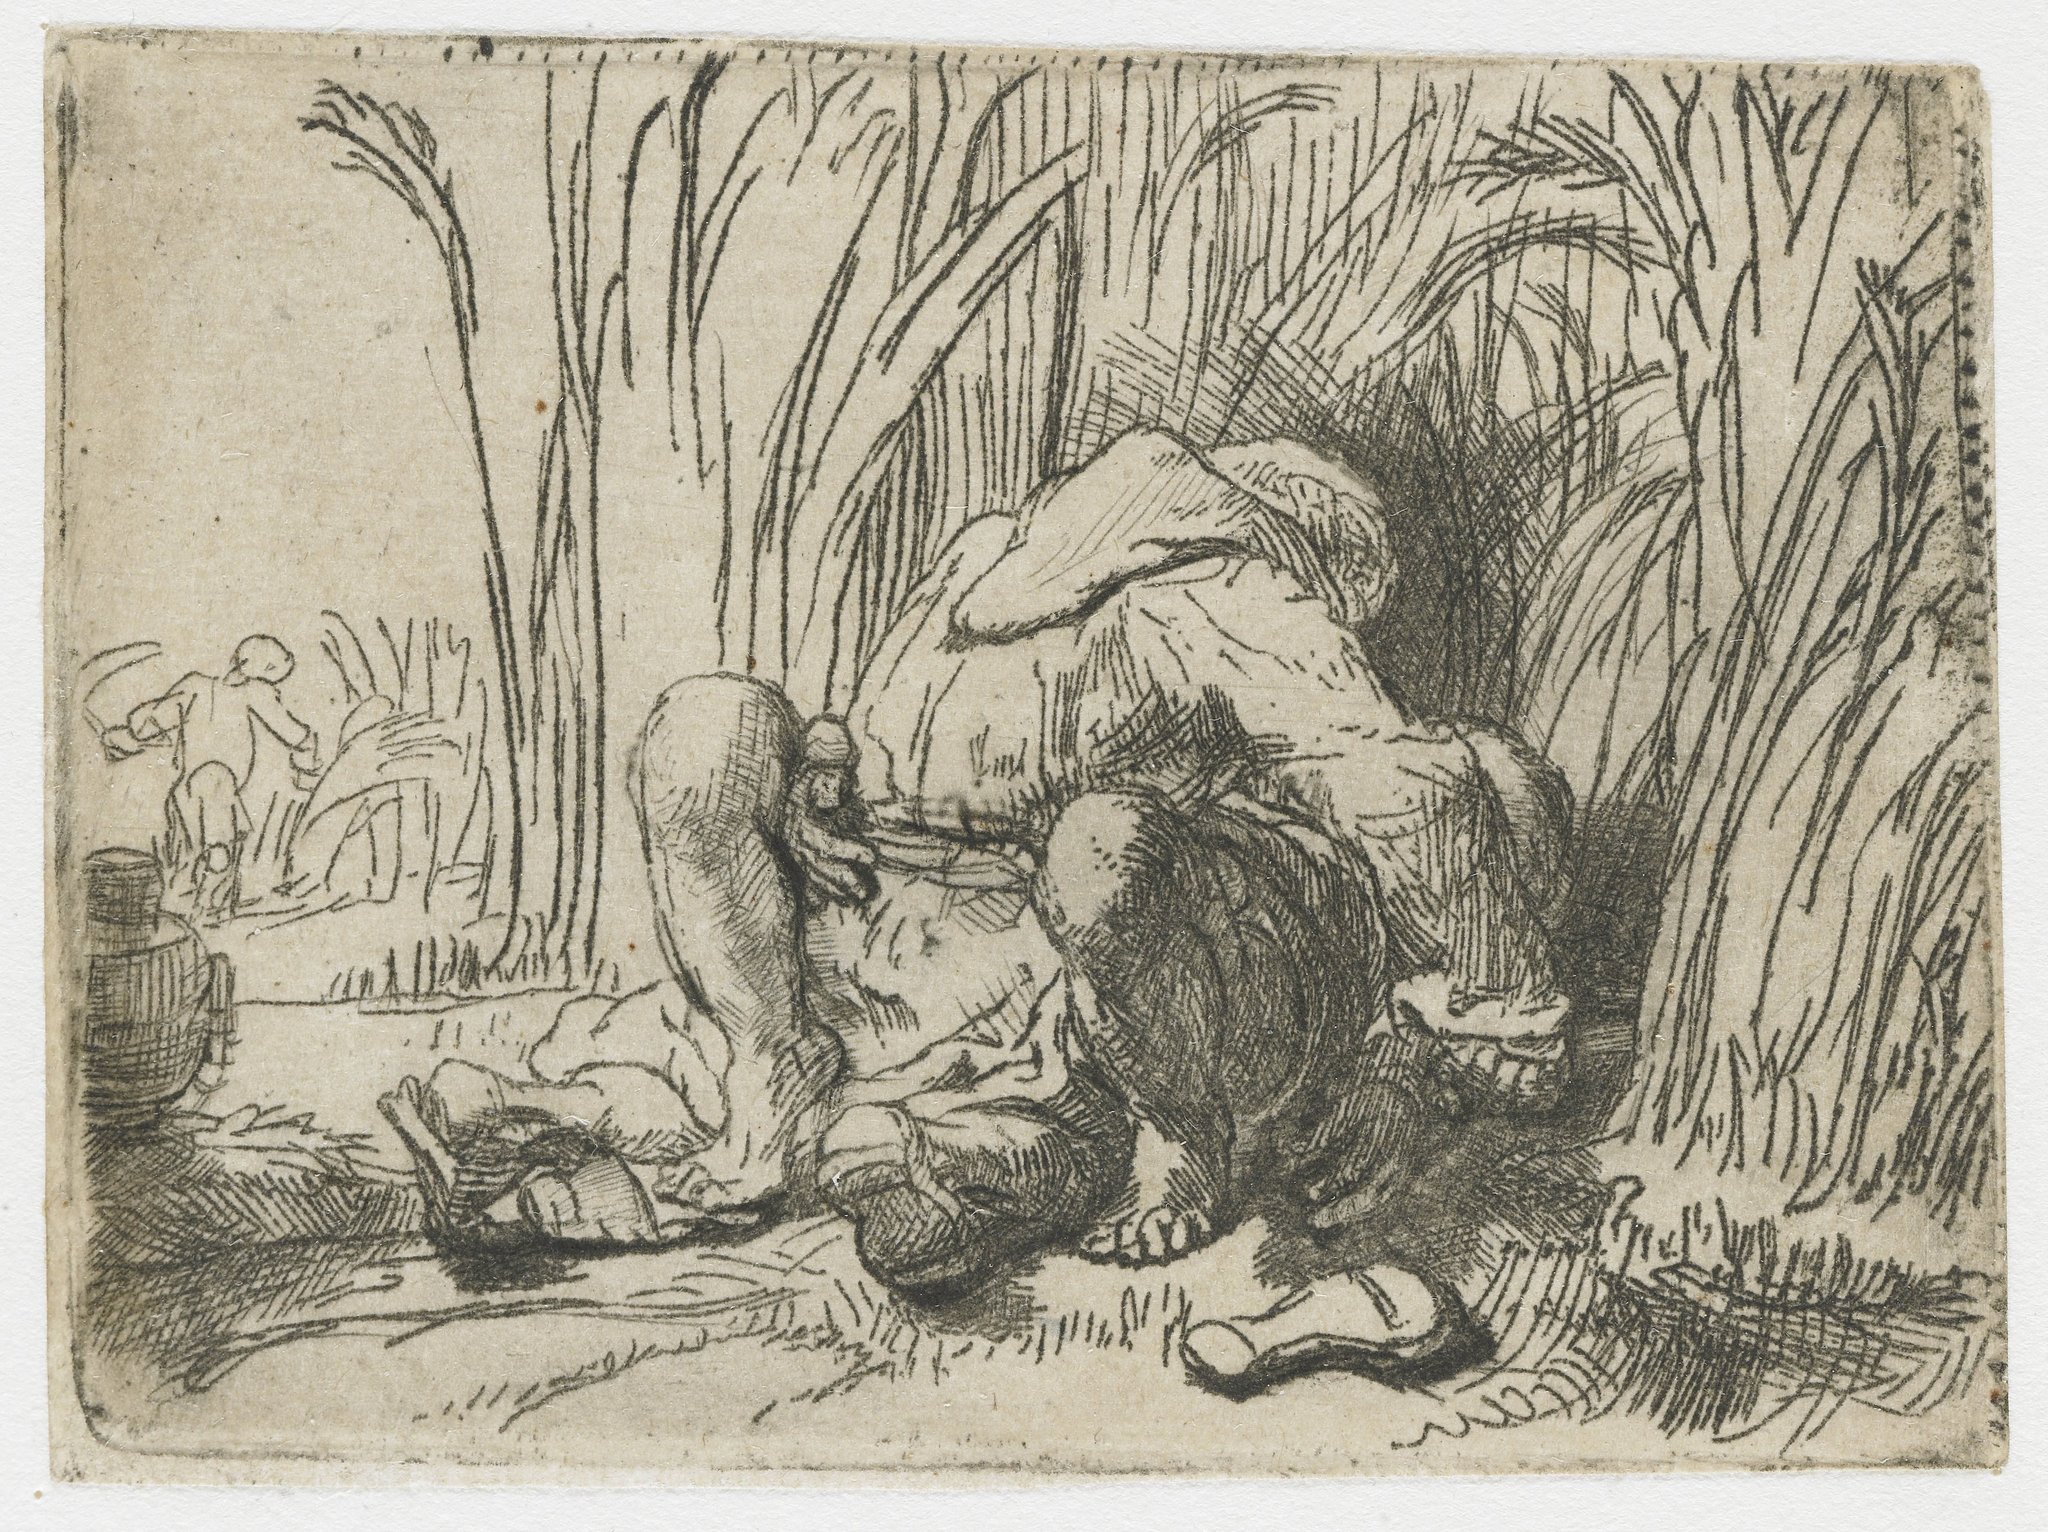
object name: print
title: The Monk in the Cornfield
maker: rembrandt van rijn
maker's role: draughtsman, painter, print maker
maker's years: 1606-1669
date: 1646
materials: paper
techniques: drypoint, etching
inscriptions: mark: Lugt 2228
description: In this highly detailed etching, a monk breaks his vow of celibacy. At the edge of a cornfield, he gives in to one of his pleasures with a woman. Fortunately, the corn is so high that the reaper further back is unaware of what is going on. Rembrandt here subscribes to the then prevailing reputation of the milkmaid – judging from the pitcher – as being licentious.